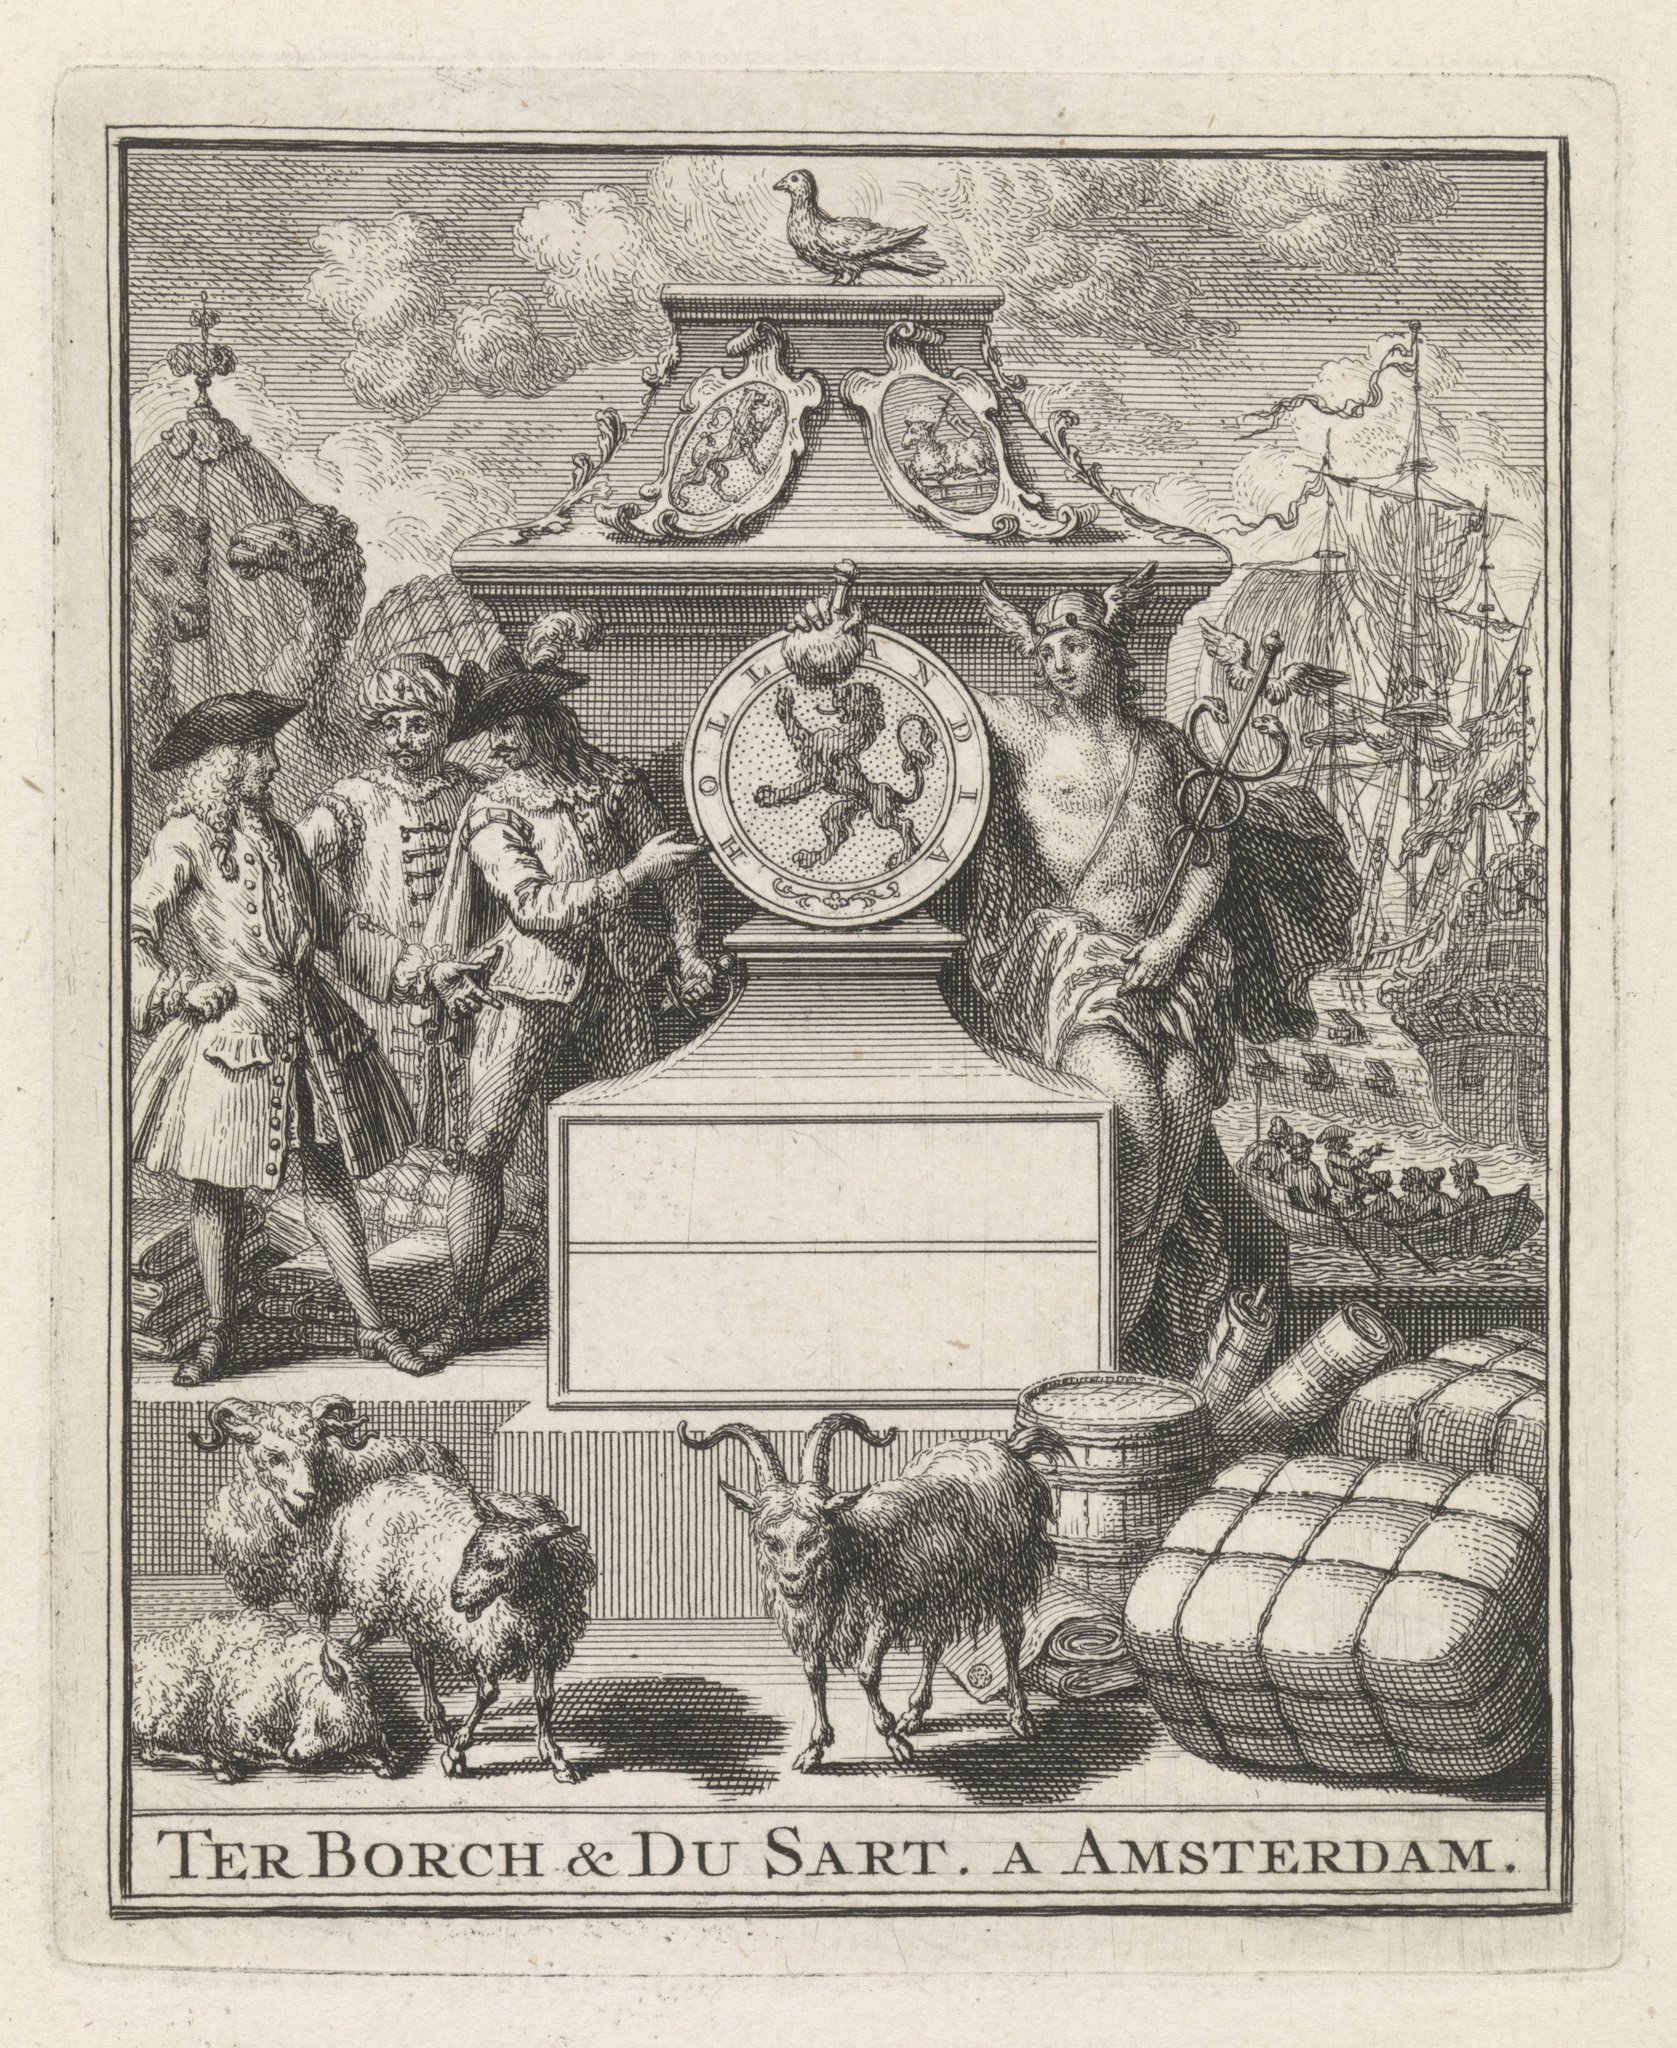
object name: print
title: Handelaren en Mercurius naast het wapen van Holland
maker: pieter tanjé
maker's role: draughtsman, print maker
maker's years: 1706-1761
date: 1716-1761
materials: paper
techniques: engraving, etching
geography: amsterdam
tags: hoofed animals: camel, trade-company, (story of) mercury (hermes), ships (in general)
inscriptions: collector's mark: Lugt 240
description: Monument met het wapen van Holland, geflankeerd door handelaren en Mercurius. Op de achtergrond kamelen en een schip. Op de voorgrond schapen, een ton en andere handelswaar. Handelsetiket voor Ter Borch & Du Sart te Amsterdam.